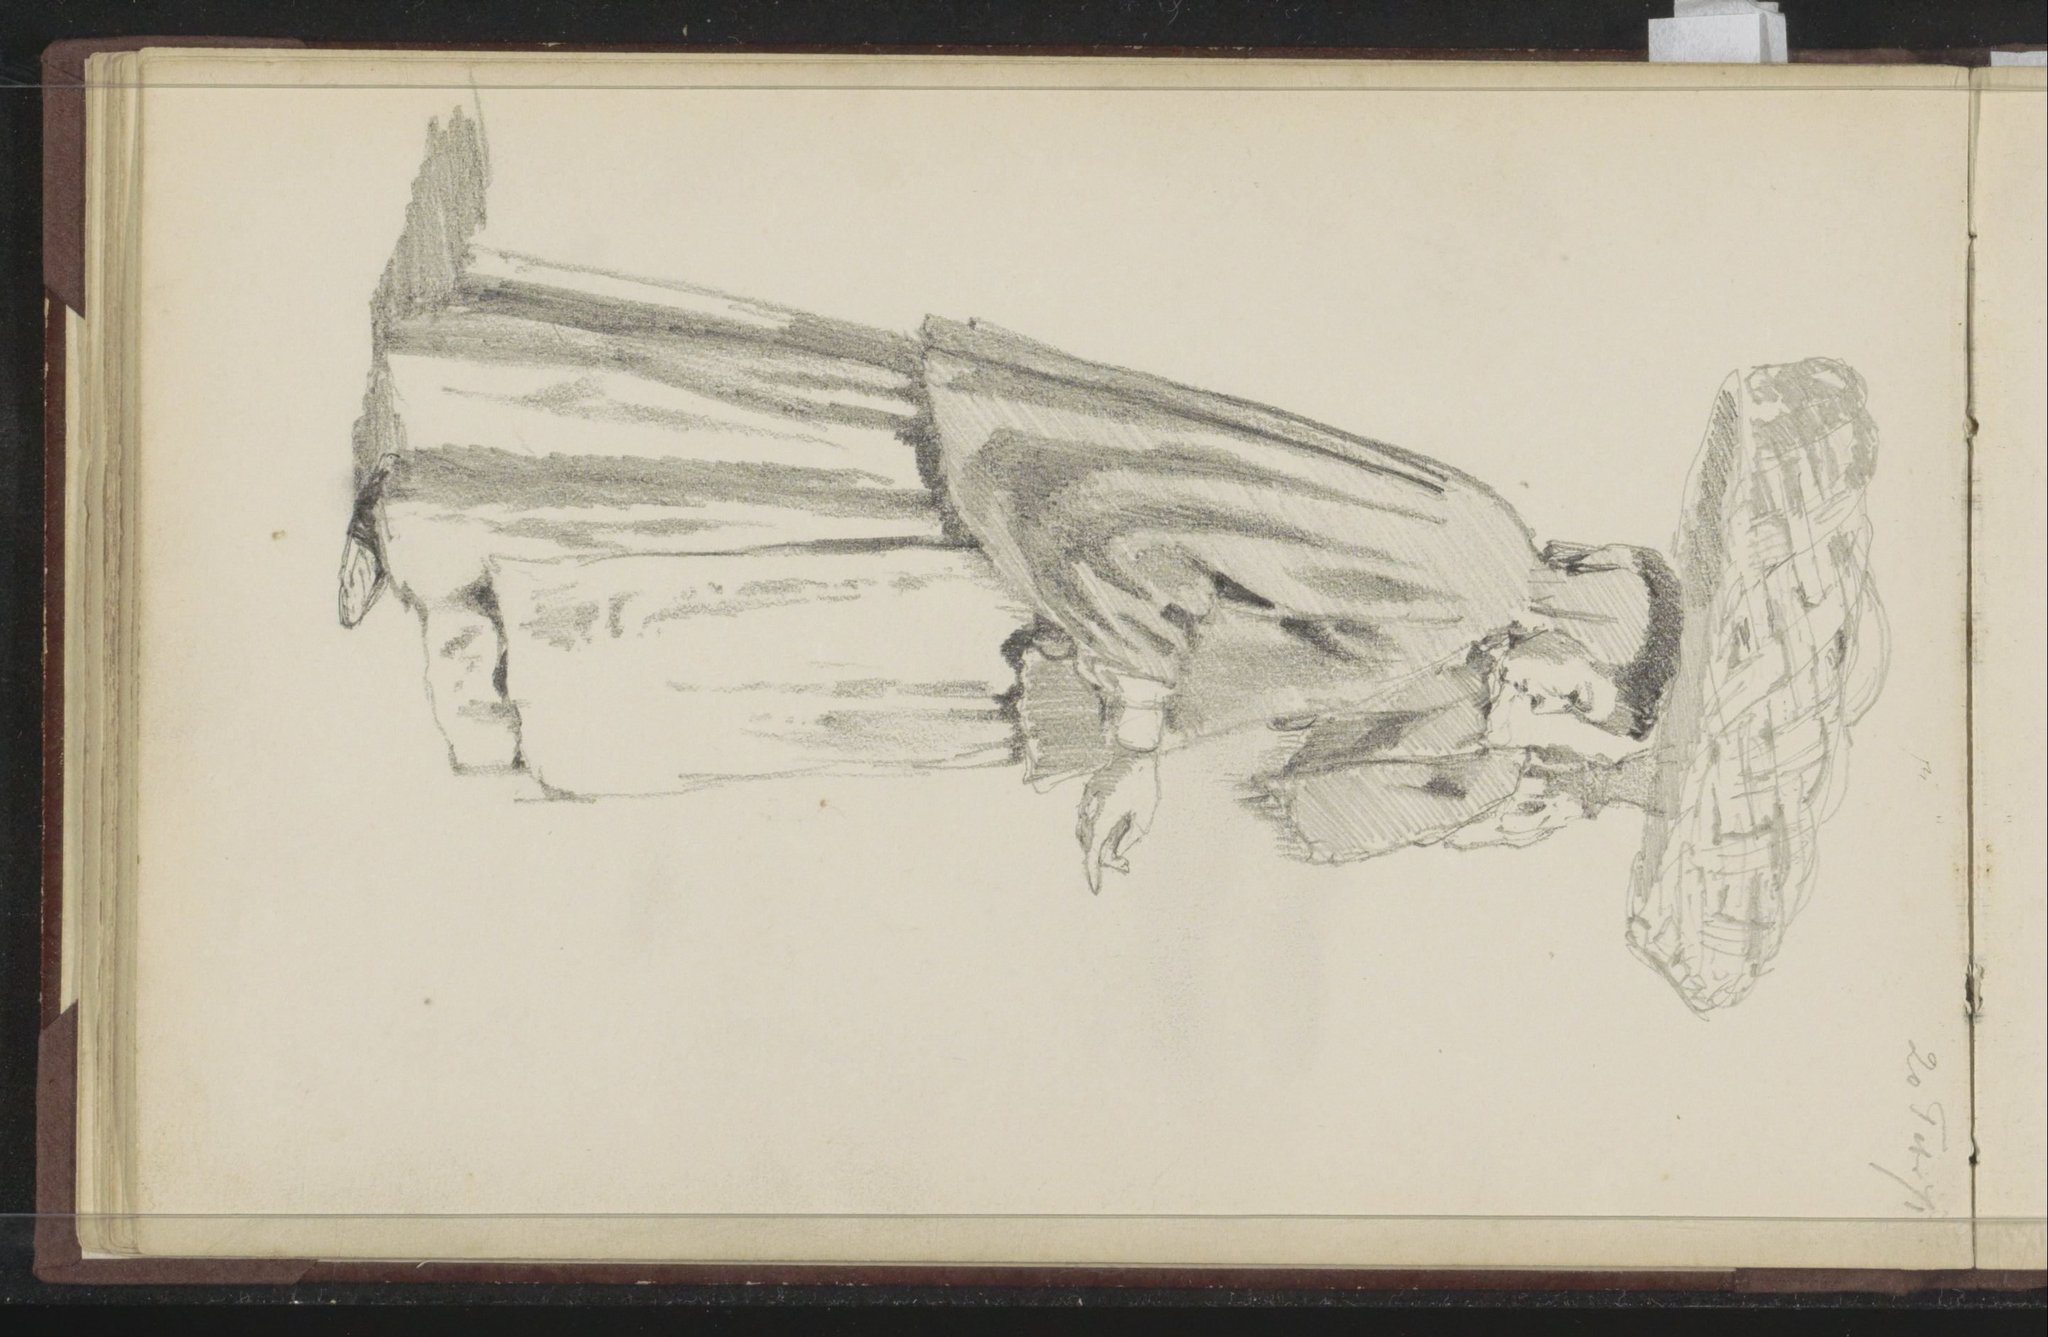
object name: sketchbook leaf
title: Vrouw met een mand op het hoofd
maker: cornelis springer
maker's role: draughtsman, painter, print maker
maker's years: 1817-1891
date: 1871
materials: paper, pencil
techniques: stumping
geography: netherlands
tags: adult woman, carrying something in basket, bag, rucksack, etc.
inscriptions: date: ‘20 Febr 71’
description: Vrouw met een mand op het hoofd. Blad 12 verso uit een schetsboek met 39 bladen, deels vervaardigd te Ulm en Leiden.